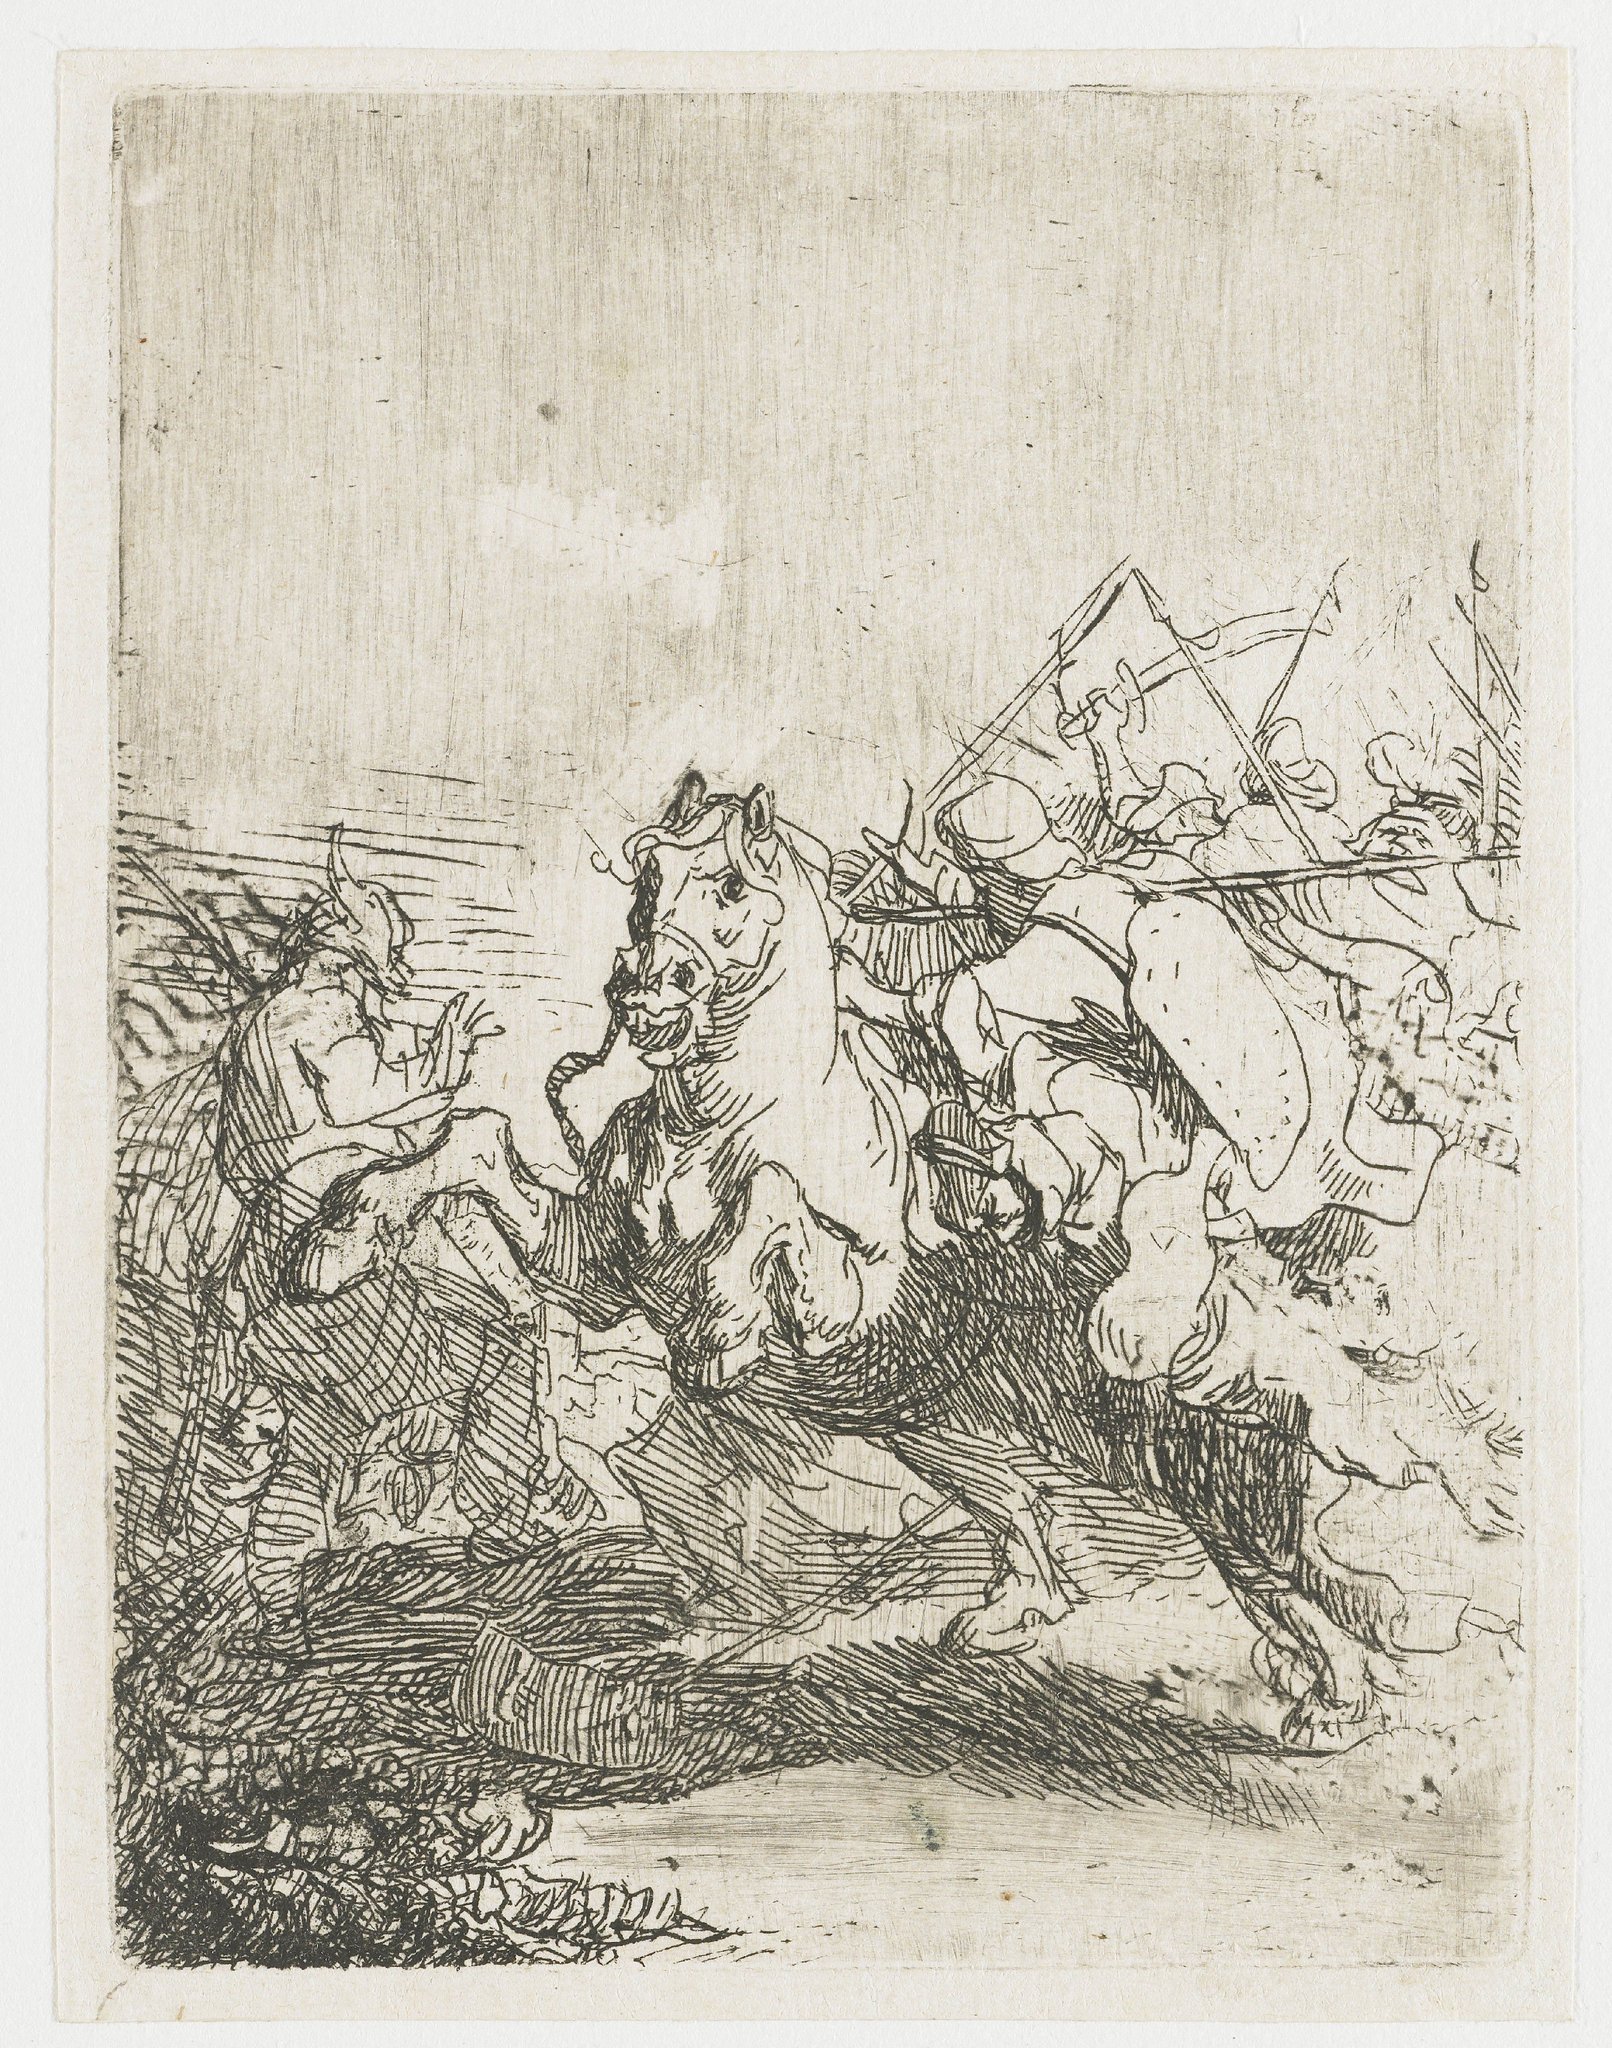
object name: print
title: A Cavalry Fight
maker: rembrandt van rijn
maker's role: draughtsman, painter, print maker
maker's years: 1606-1669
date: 1629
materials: paper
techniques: etching, intaglio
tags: warfare; military affairs (+ cavalry, horsemen)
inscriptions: collector's mark: Lugt 240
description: At times, it is not at all obvious what Rembrandt is trying to tell us. For example, in the top print he depicts a horseman, without any indication of what exactly is going on. In the bottom print, a cavalry encounter, with much clashing of arms, seems to be taking place; however, that does not explain what is happening. Perhaps Rembrandt was interested chiefly in rendering chaos and movement.